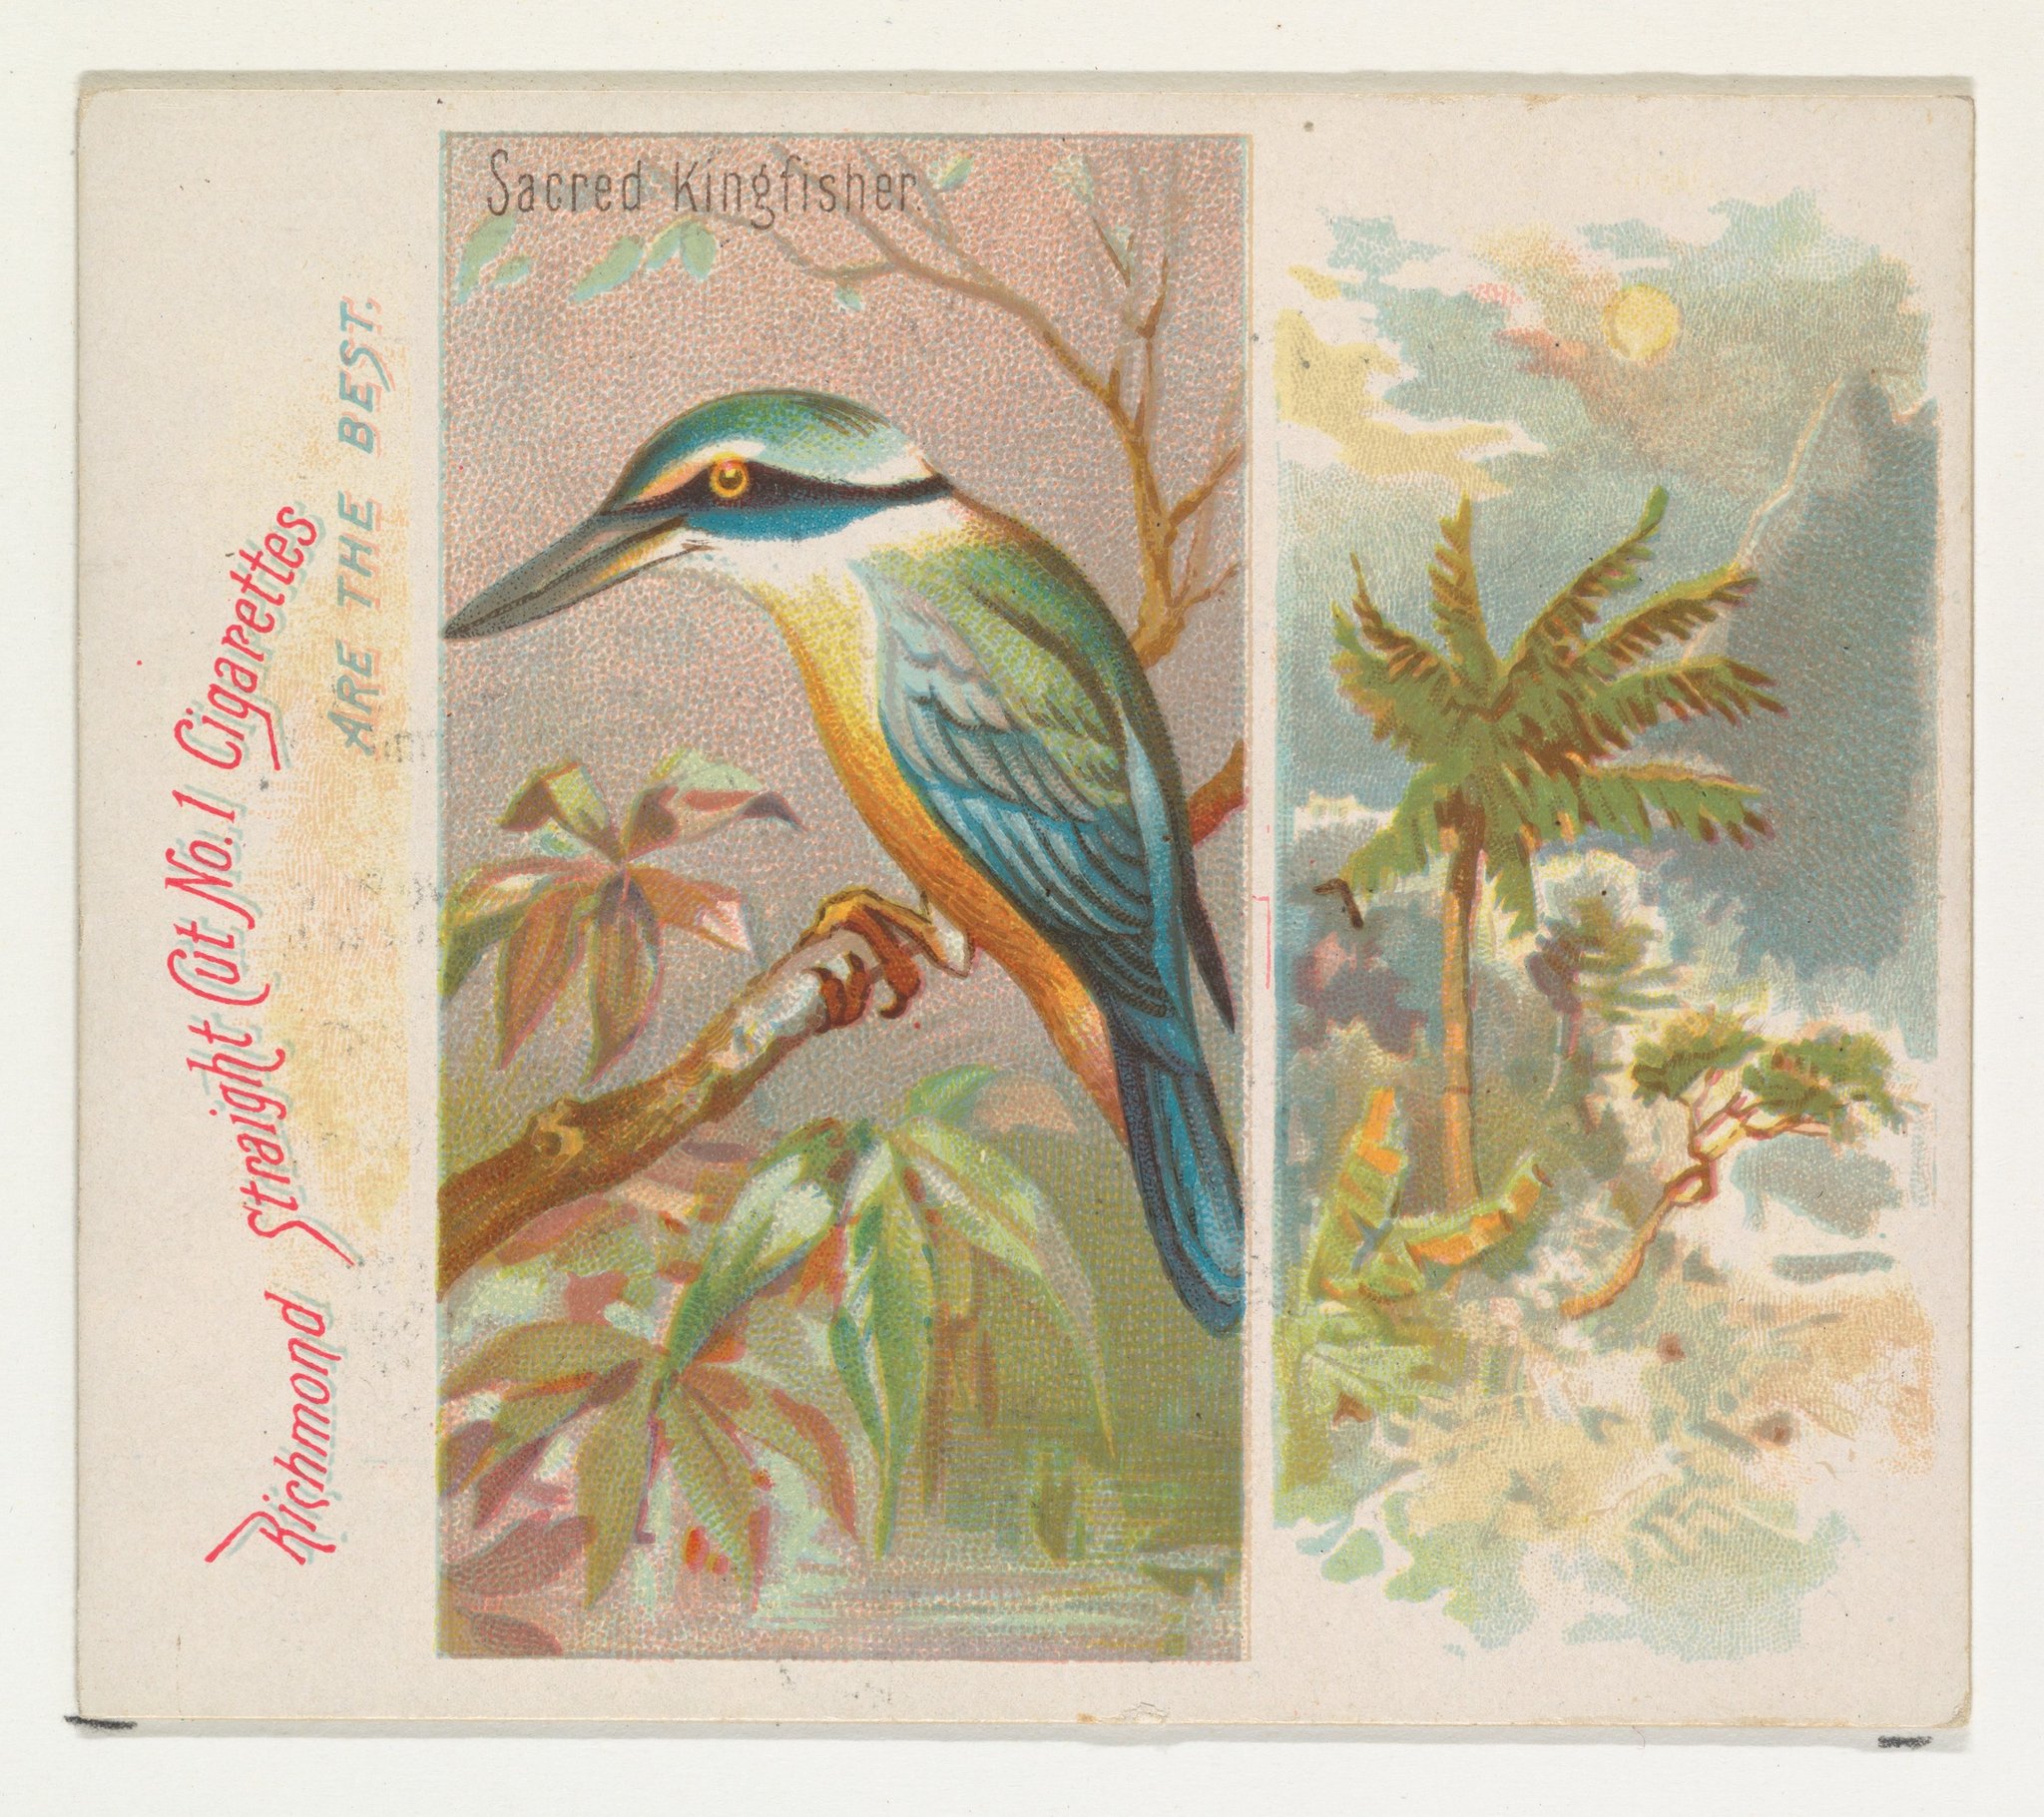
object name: print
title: Sacred Kingfisher, from Birds of the Tropics series (N38) for Allen & Ginter Cigarettes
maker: allen & ginter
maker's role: publisher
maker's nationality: american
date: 1889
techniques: color lithograph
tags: birds